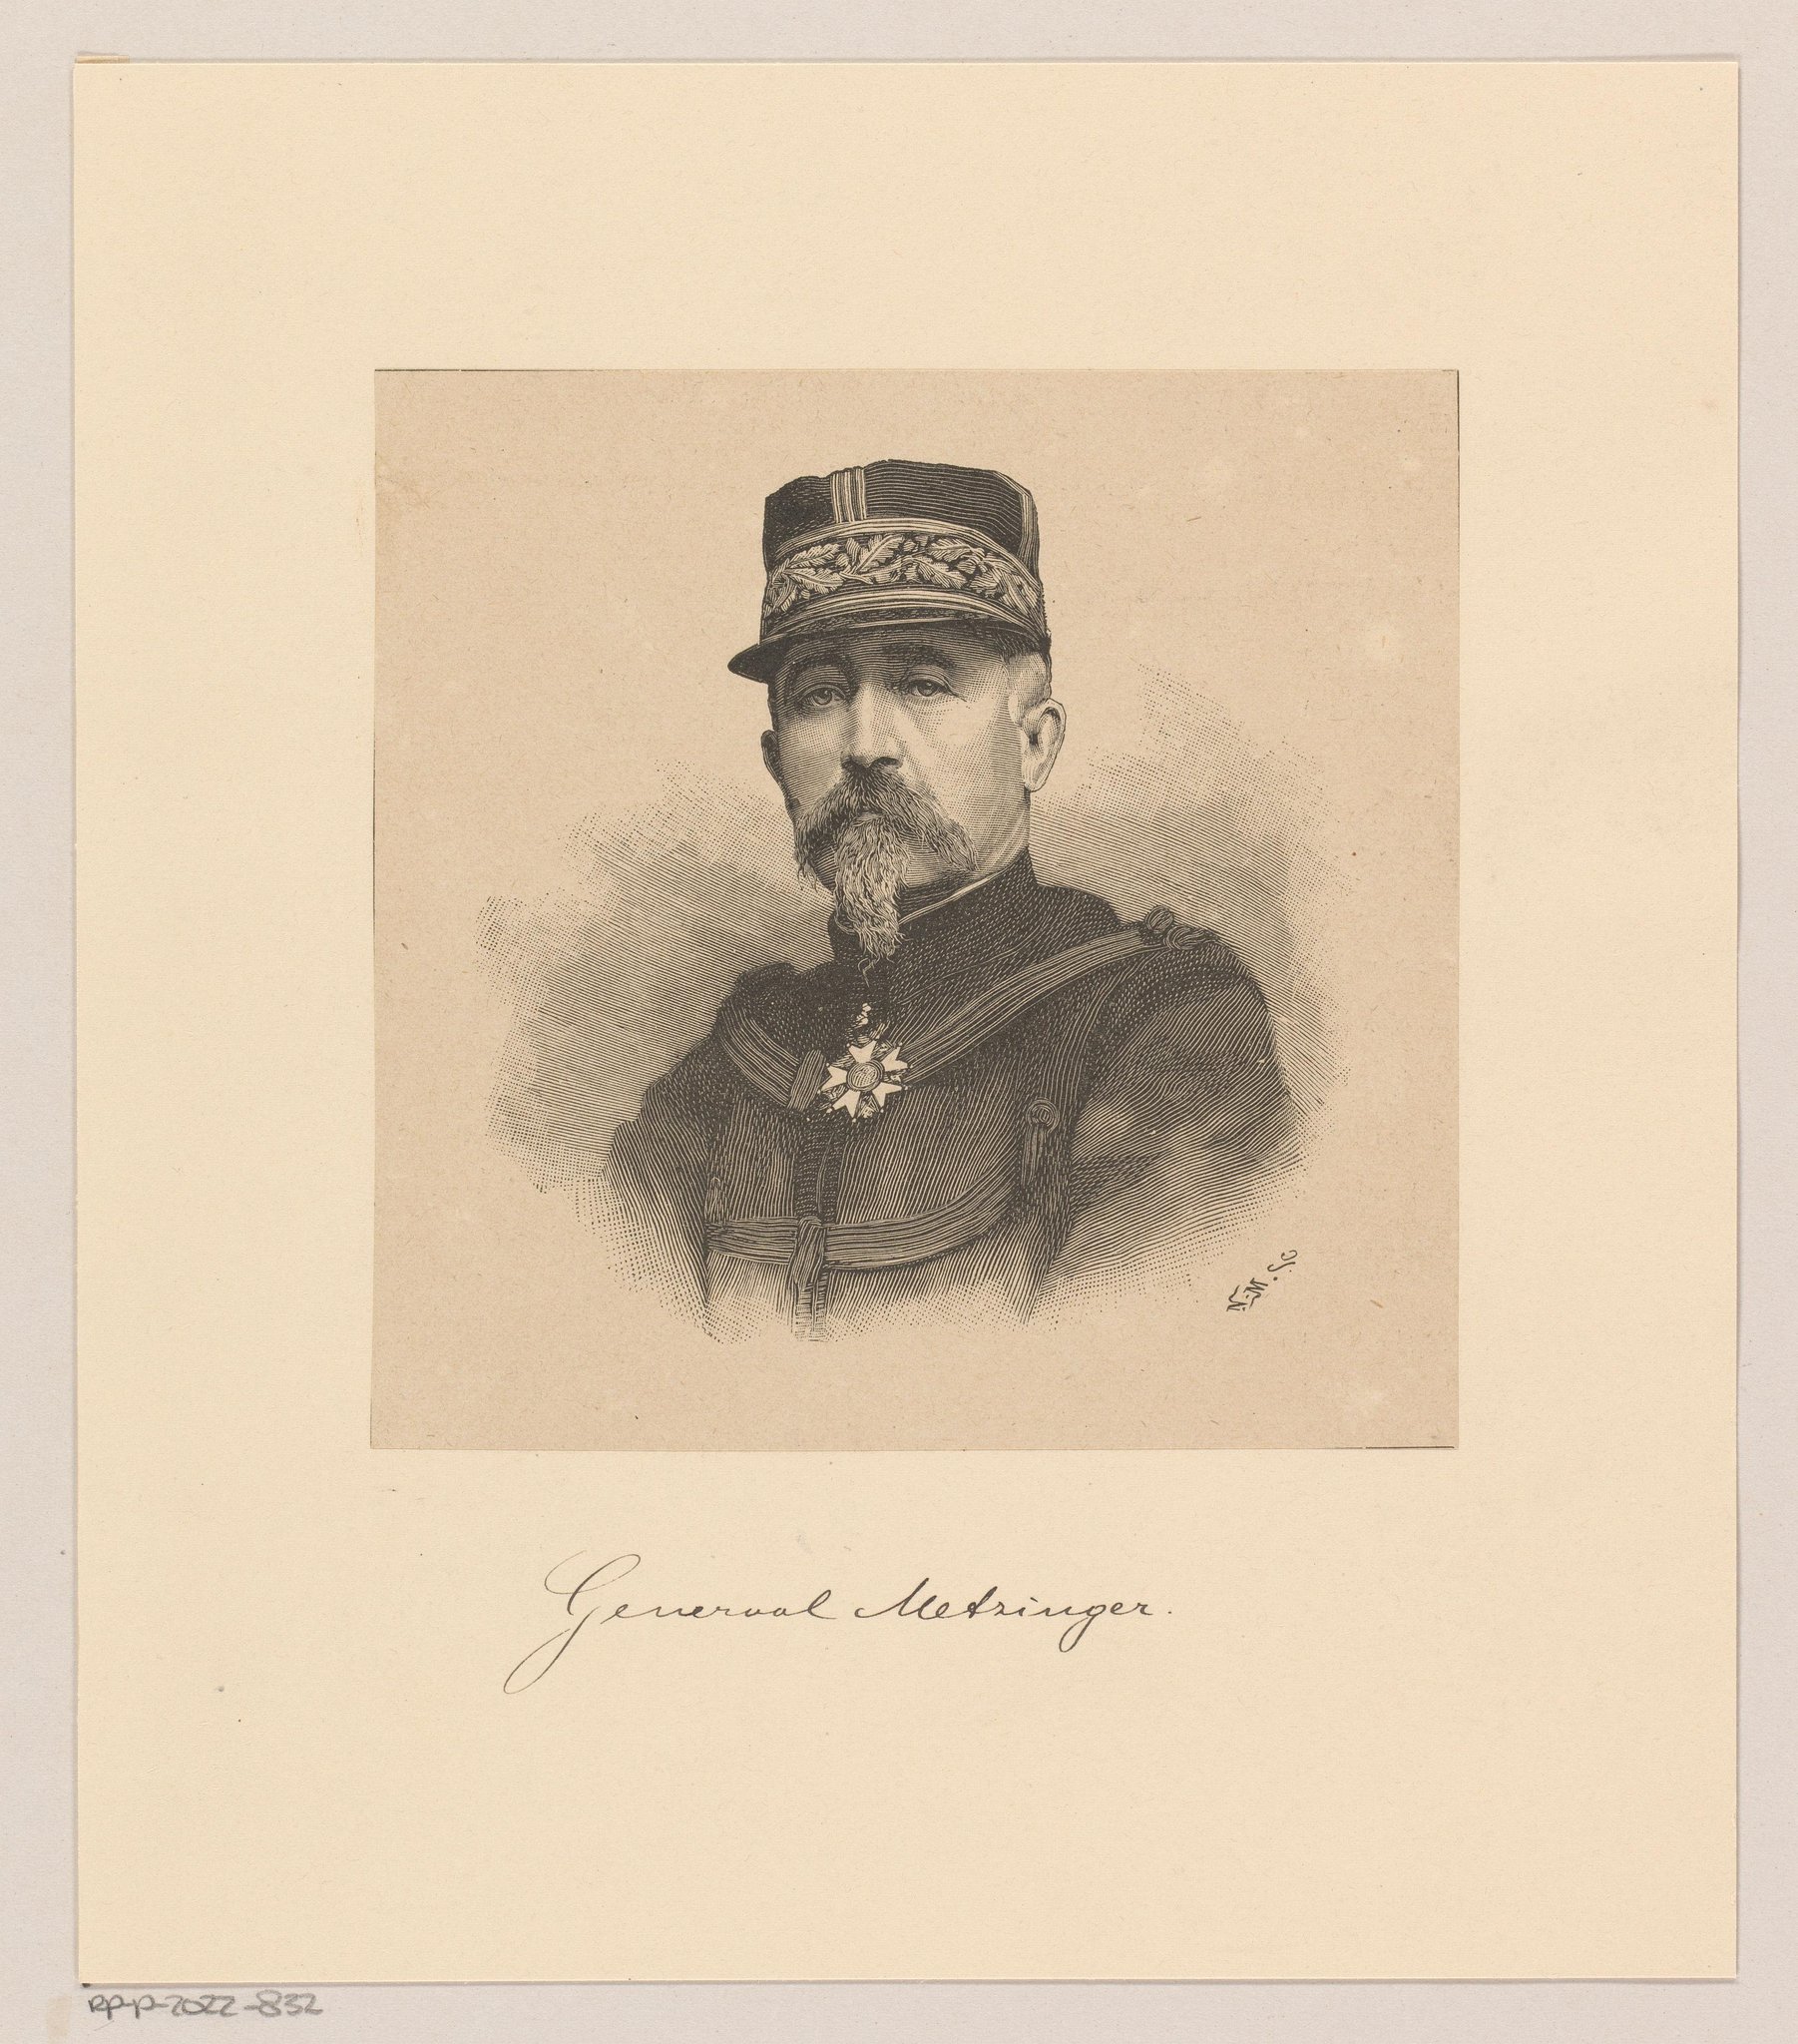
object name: print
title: Portret van Léon Frédéric Hubert Metzinger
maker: monogrammist nm (19e eeuw)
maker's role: print maker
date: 1895-1950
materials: paper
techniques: snipping, engraving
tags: historical persons